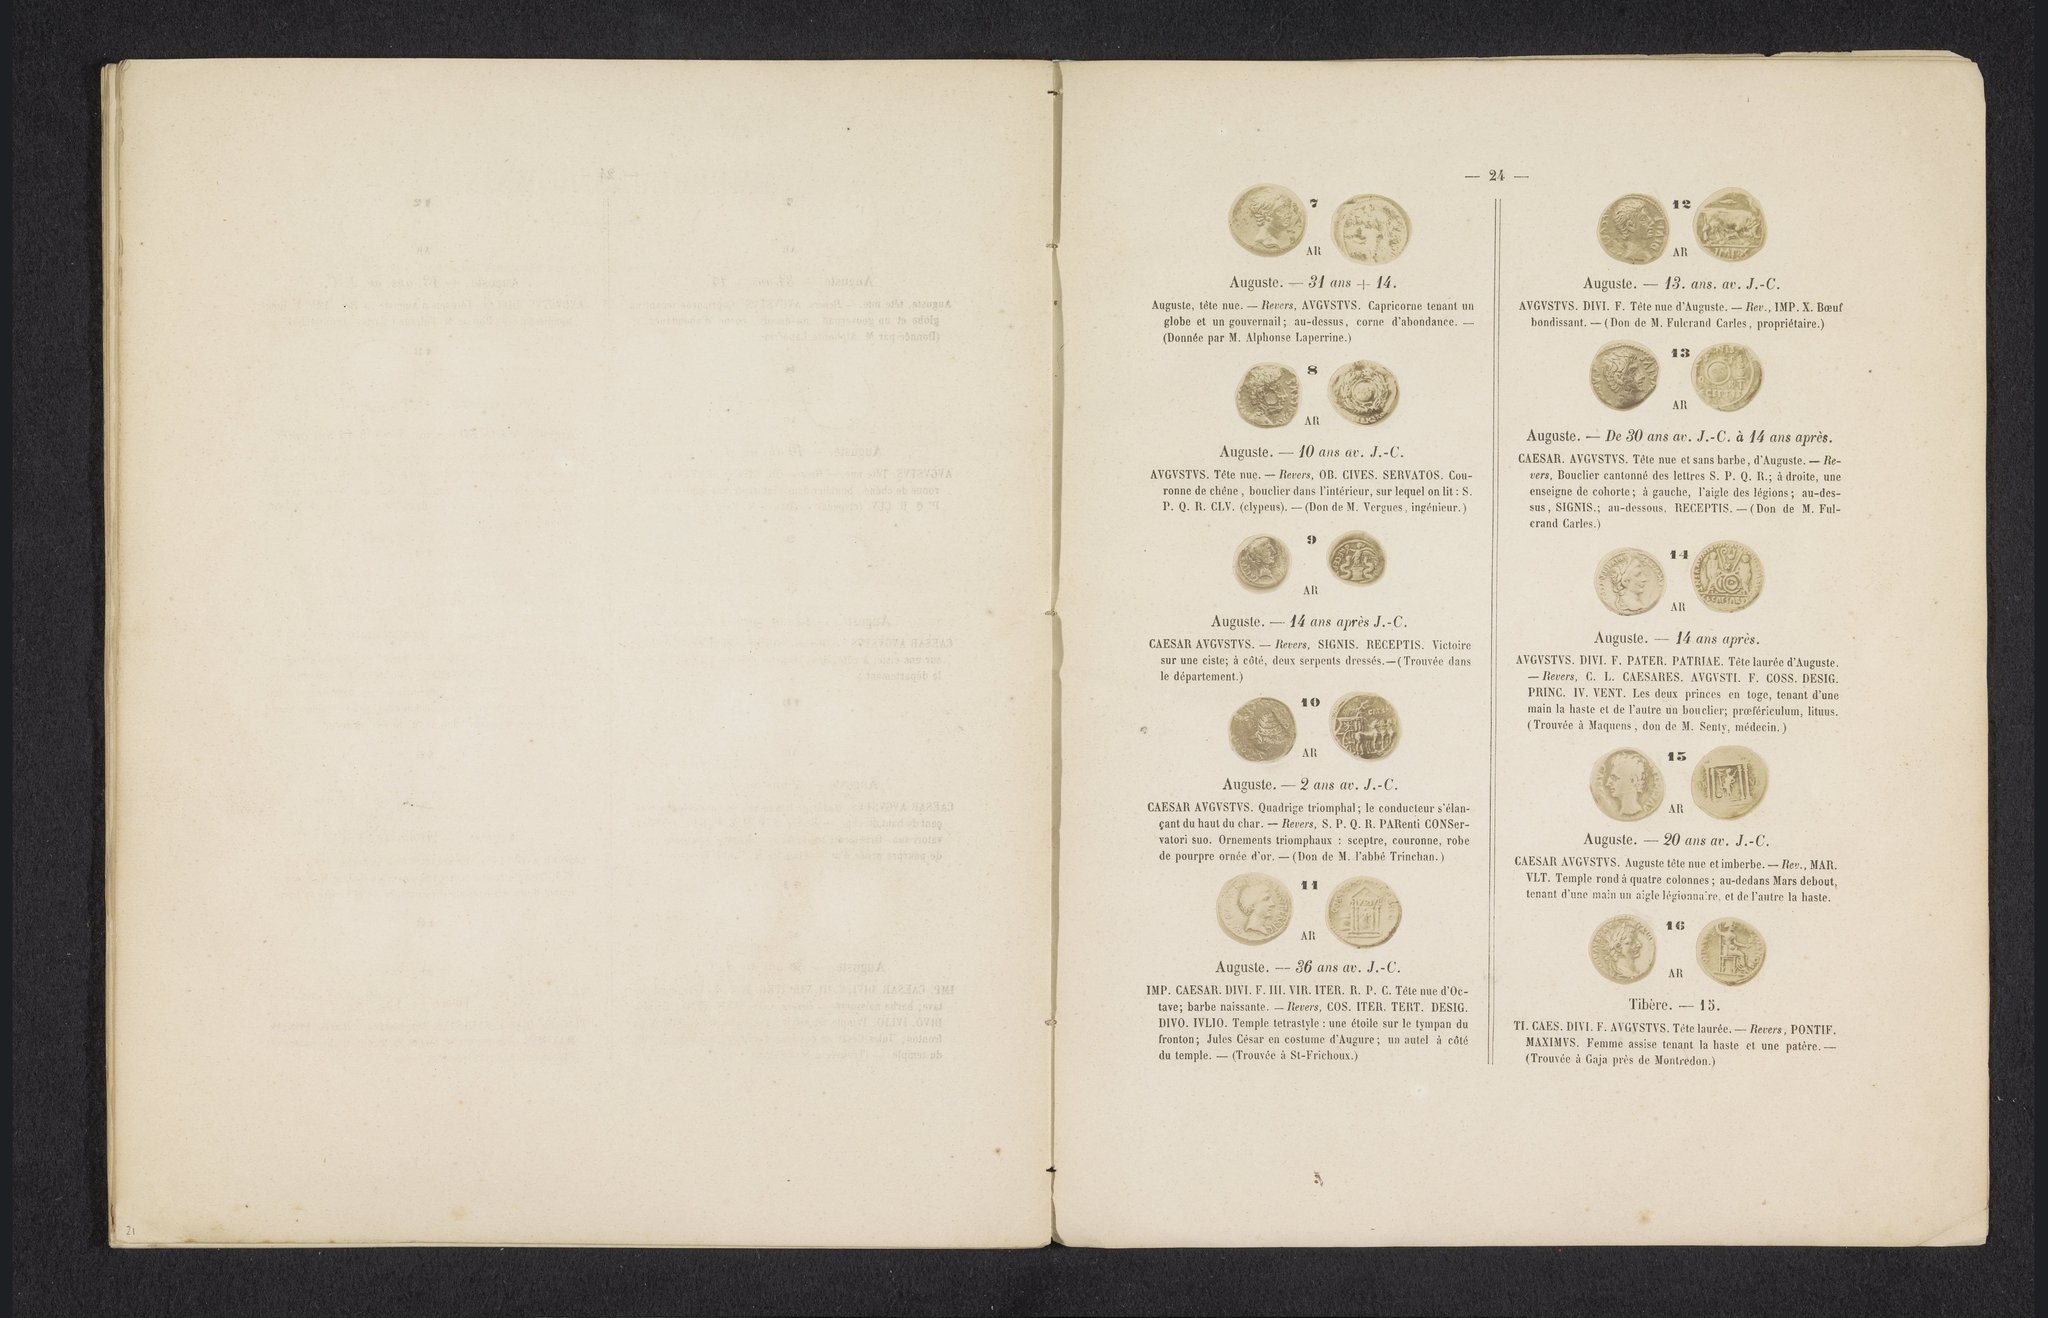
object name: page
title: Tien munten met Romeinse keizers, gezien van voor- en achterkant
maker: léopold verguet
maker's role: abt, fotograaf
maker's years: 1817-1914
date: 1854-1864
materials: photographic support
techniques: albumen print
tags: miseno, coin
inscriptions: number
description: Nummers 7 tot en met 15: Augustus nummer 16: Tiberius.